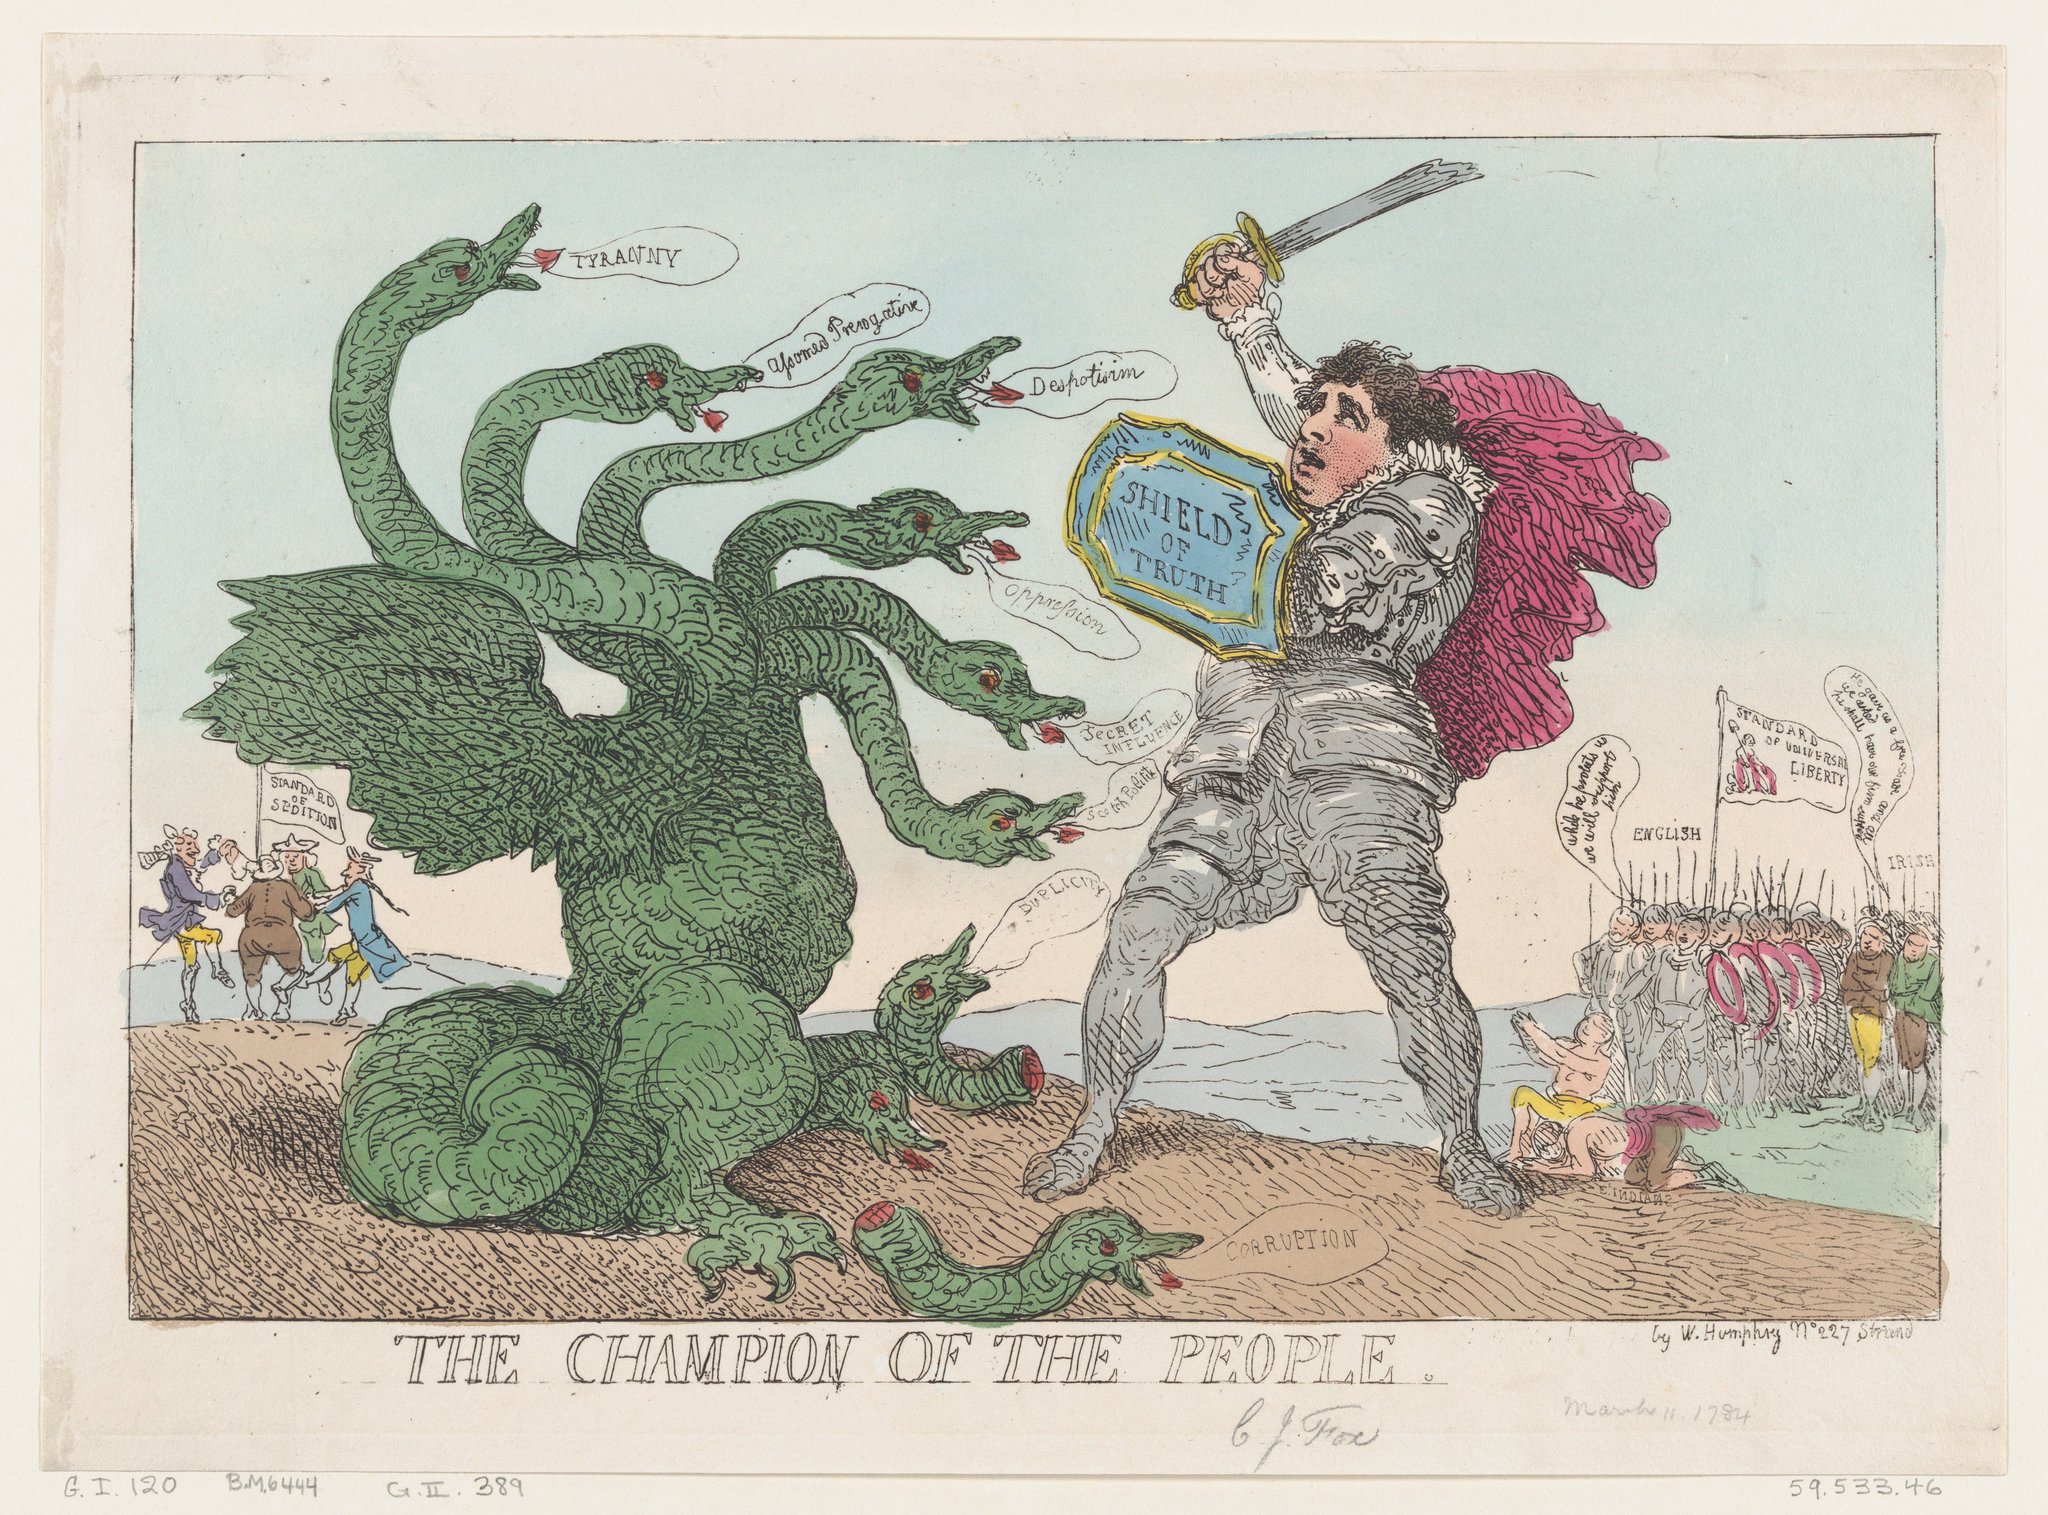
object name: print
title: The Champion of the People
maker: thomas rowlandson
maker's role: artist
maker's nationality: british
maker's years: 1757-1827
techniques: etching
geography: london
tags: satire,men,monsters,politics